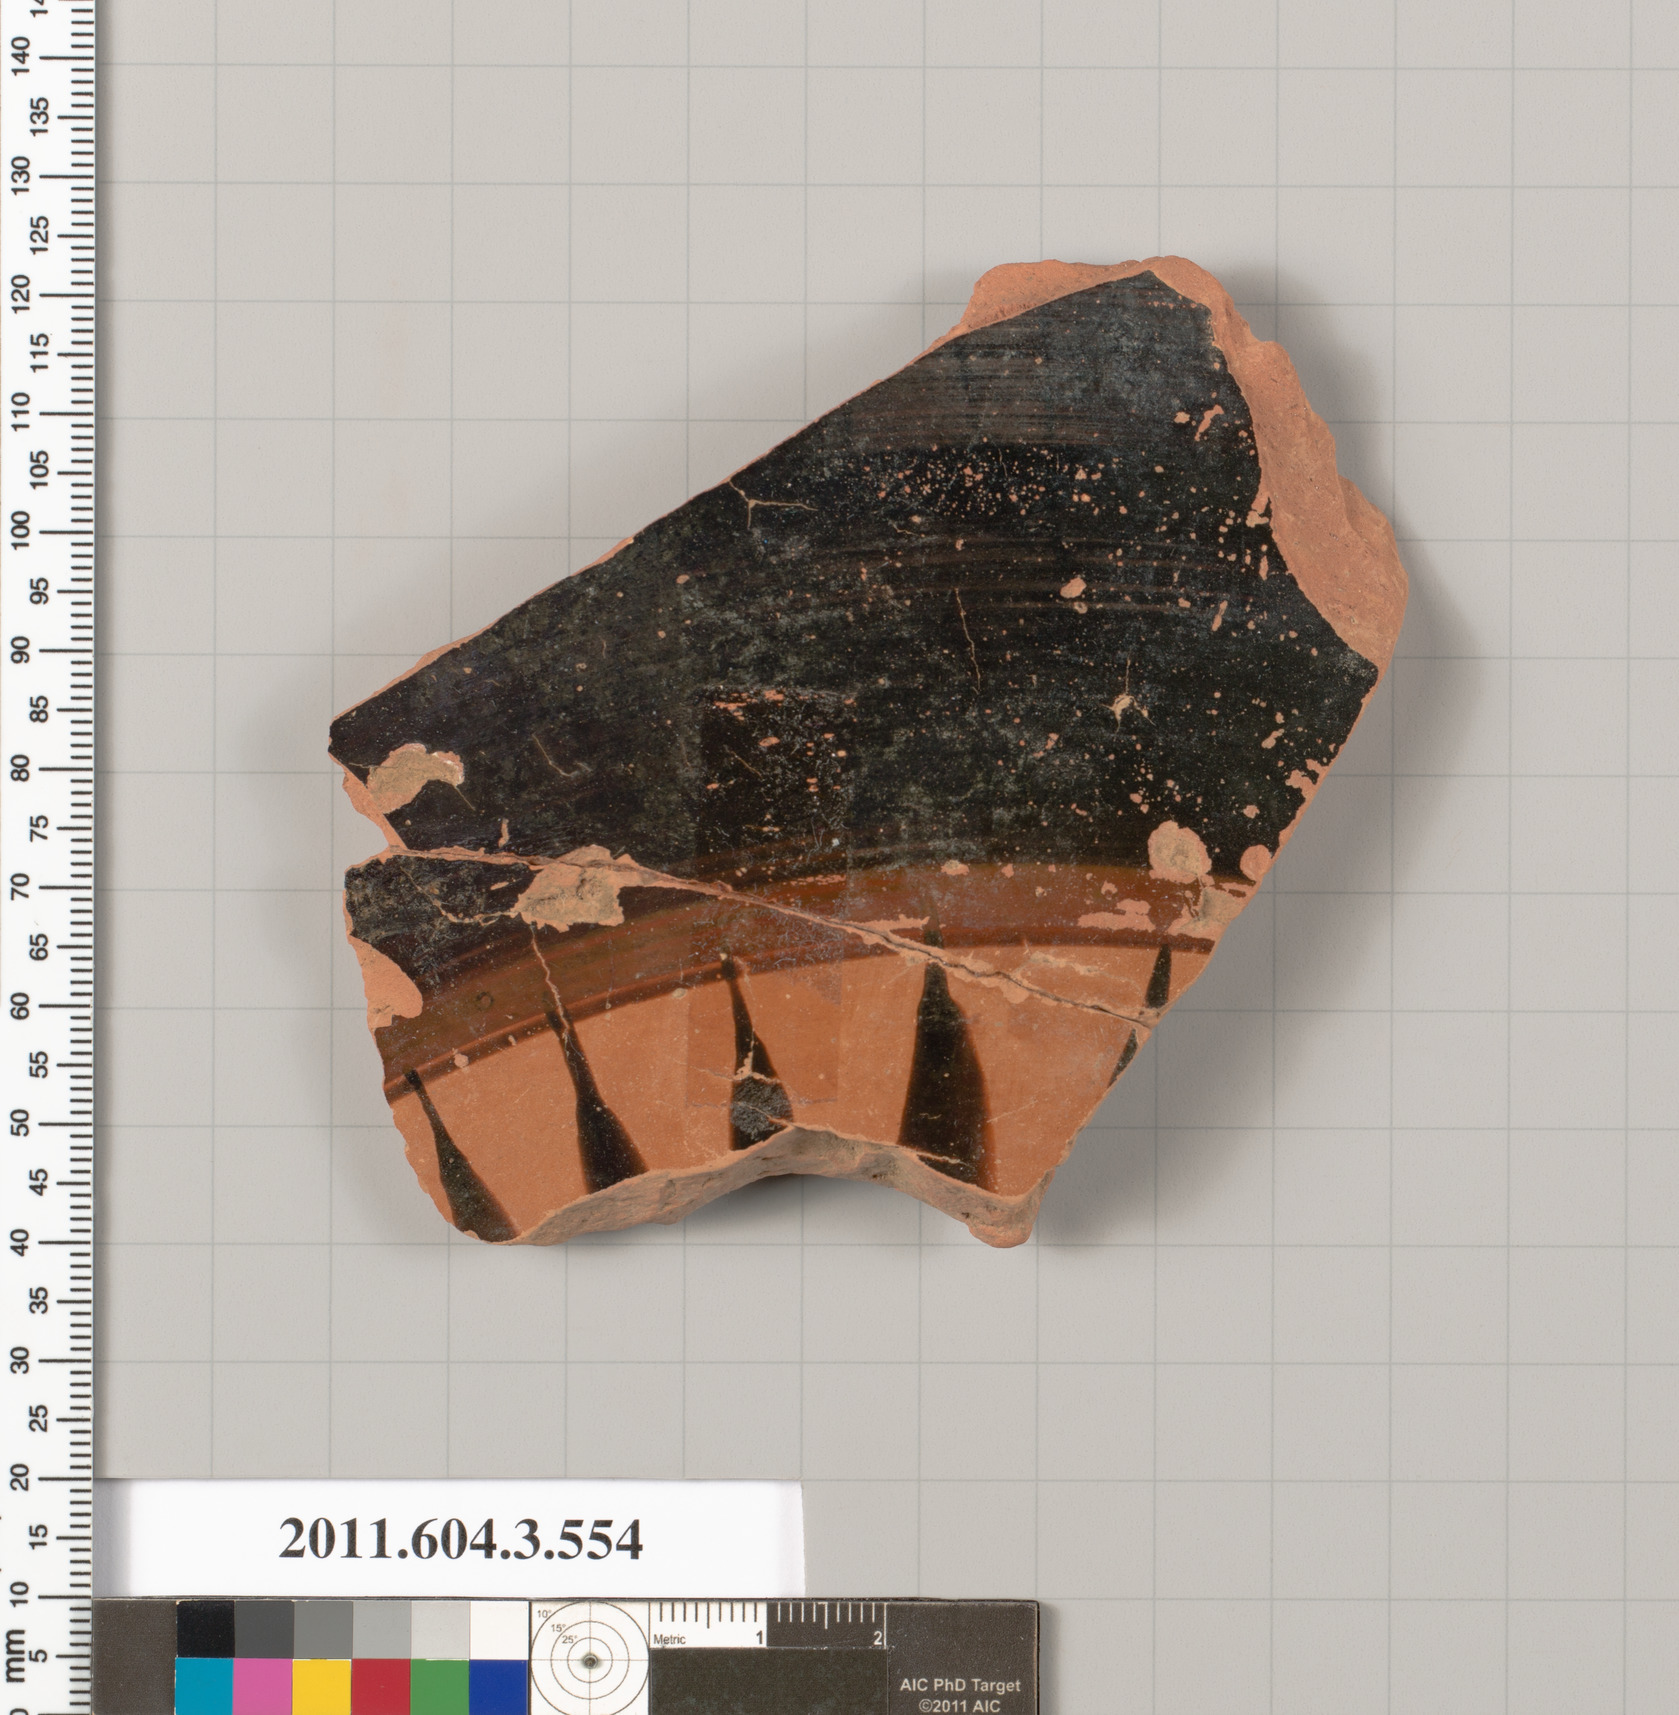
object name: column krater fragment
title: Terracotta fragment of a column-krater (bowl for mixing wine and water)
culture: greek, attic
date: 600-401 BCE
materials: terracotta